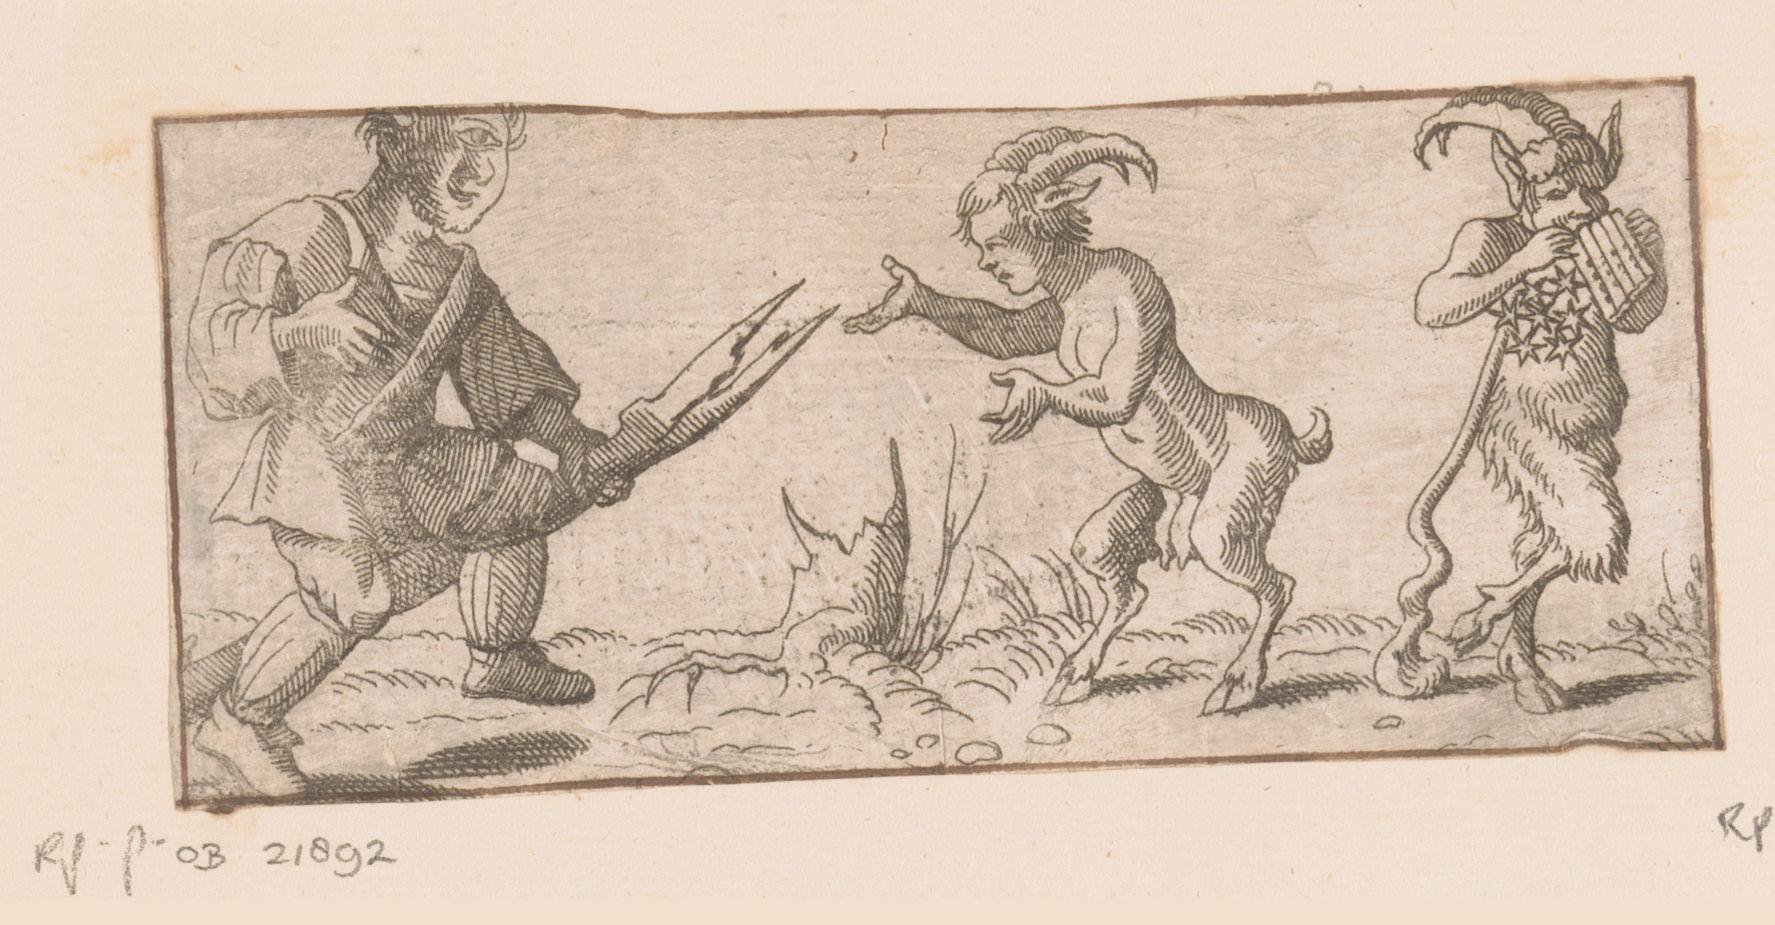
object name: book illustration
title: Illustraties uit de Lof der Zotheid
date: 1516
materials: paper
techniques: etching, letterpress printing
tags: dancing, (story of) pan, satyr(s) (in general), polyphemus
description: Prent afkomstig uit: Erasmus, Desiderius. Morias enkomion (...). Bazel: Johann Rudolf Genath, 1676. De prenten hierin zijn naar tekeningen die Hans en Ambrosius Holbein maakten voor de theoloog Oswald Myconius in diens uitgave van de Moriae encomium (Lof der Zotheid) van 1516.